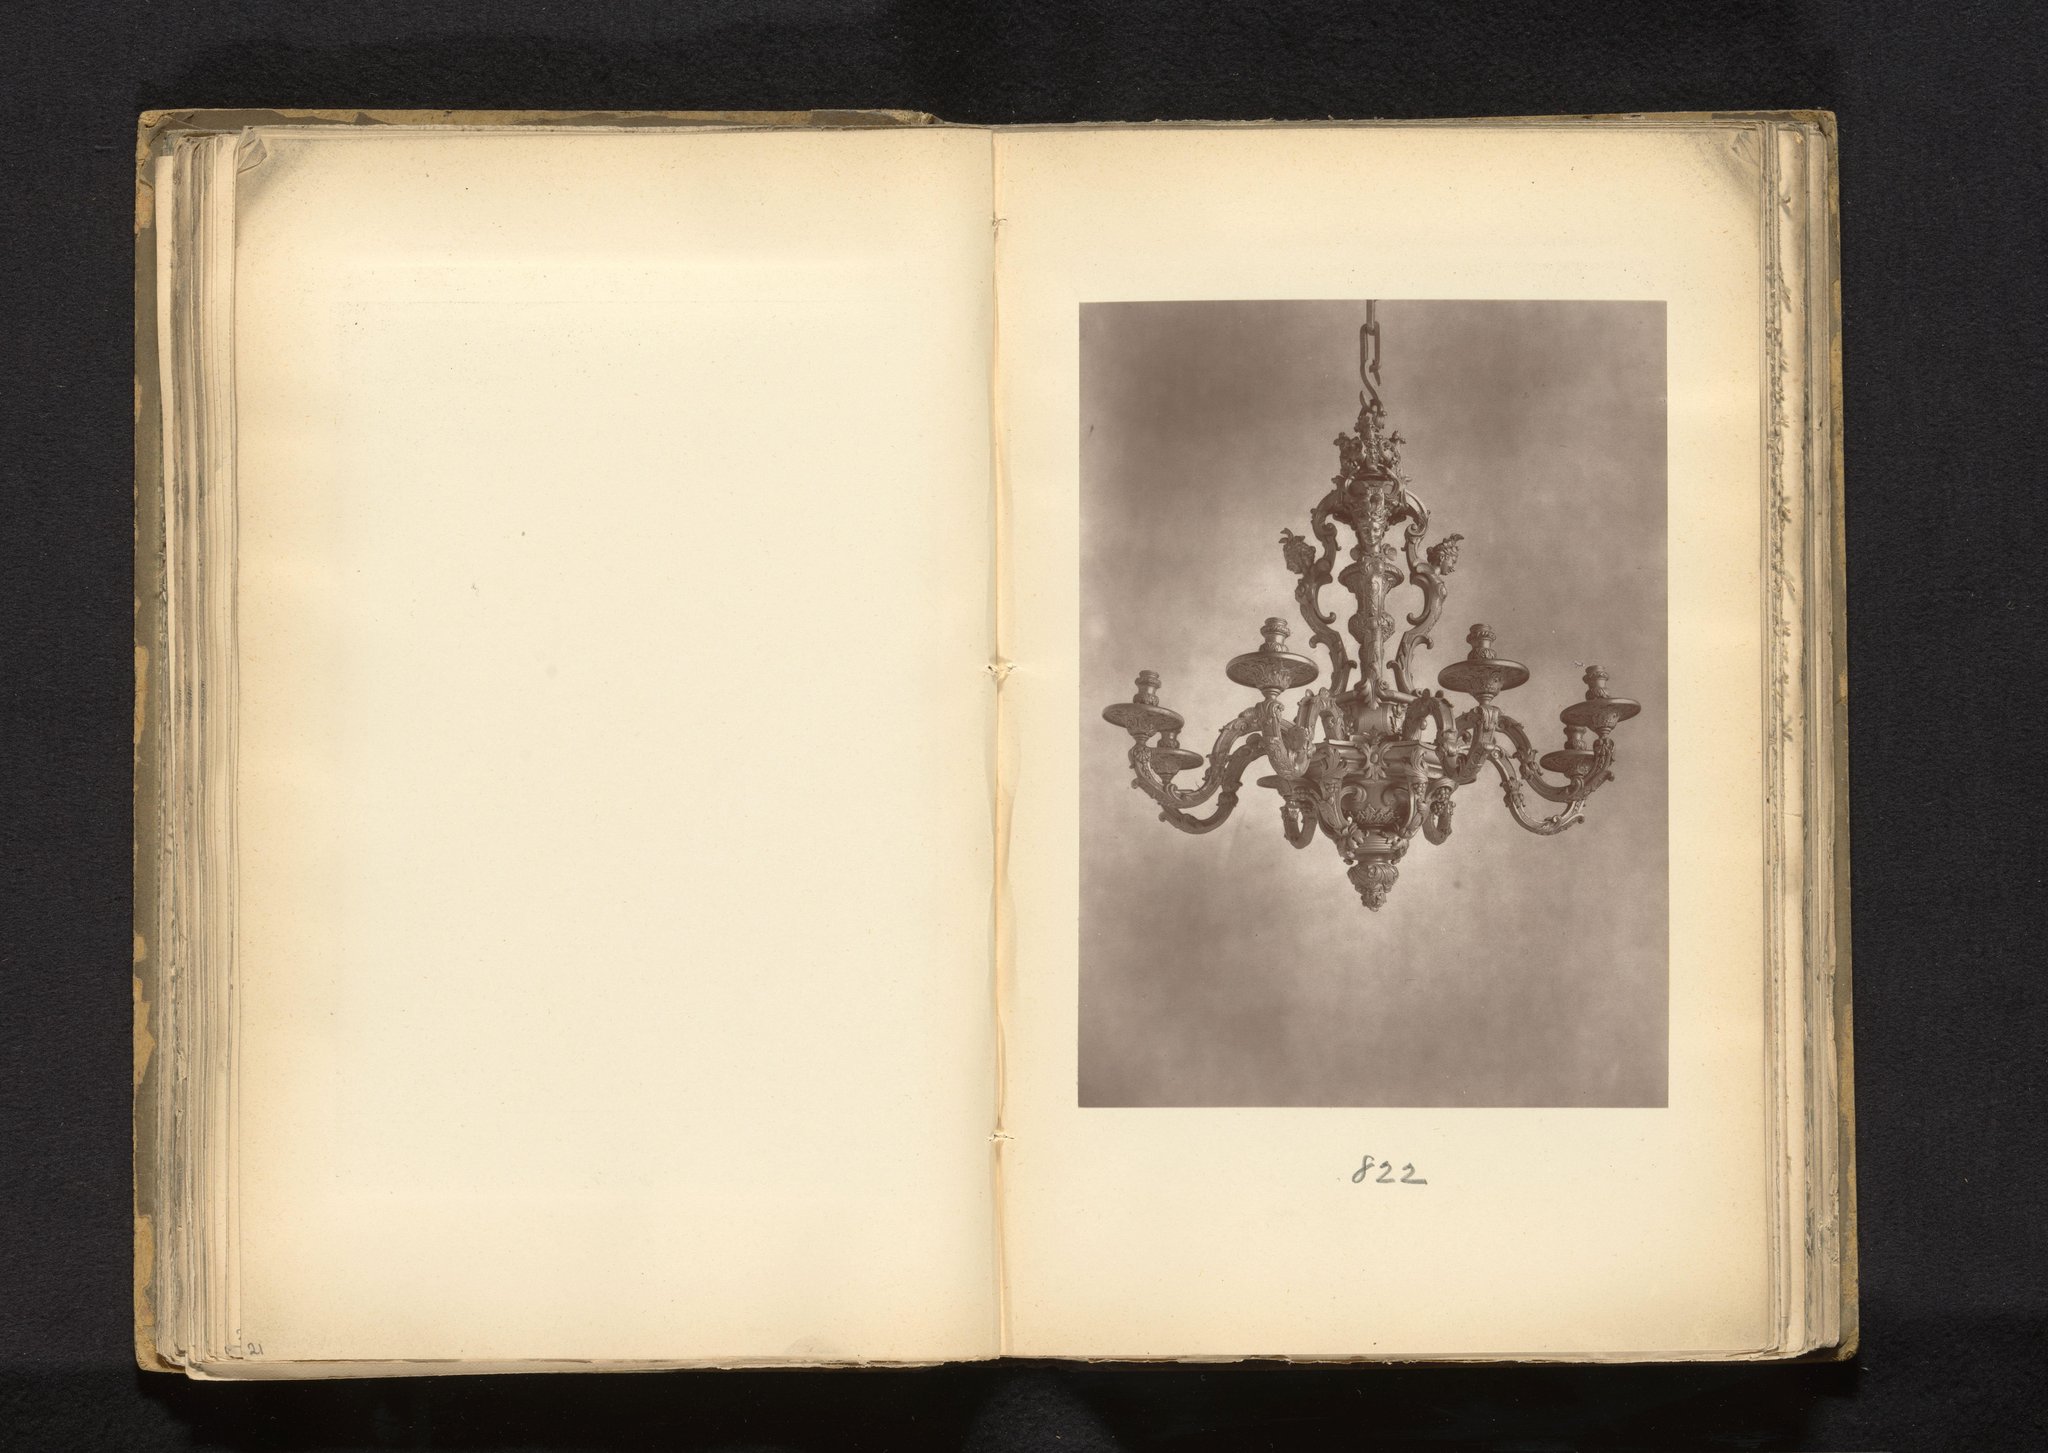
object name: page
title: Kroonluchter in de stijl van Lodewijk XIV, uit de collectie van Christopher Beckett Denison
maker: Anonymous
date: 1880-1885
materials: paper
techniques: woodburytype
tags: chandelier, candelabrum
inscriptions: number: ‘822’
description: Prent op vijfde ongenummerde pagina na pagina 82.